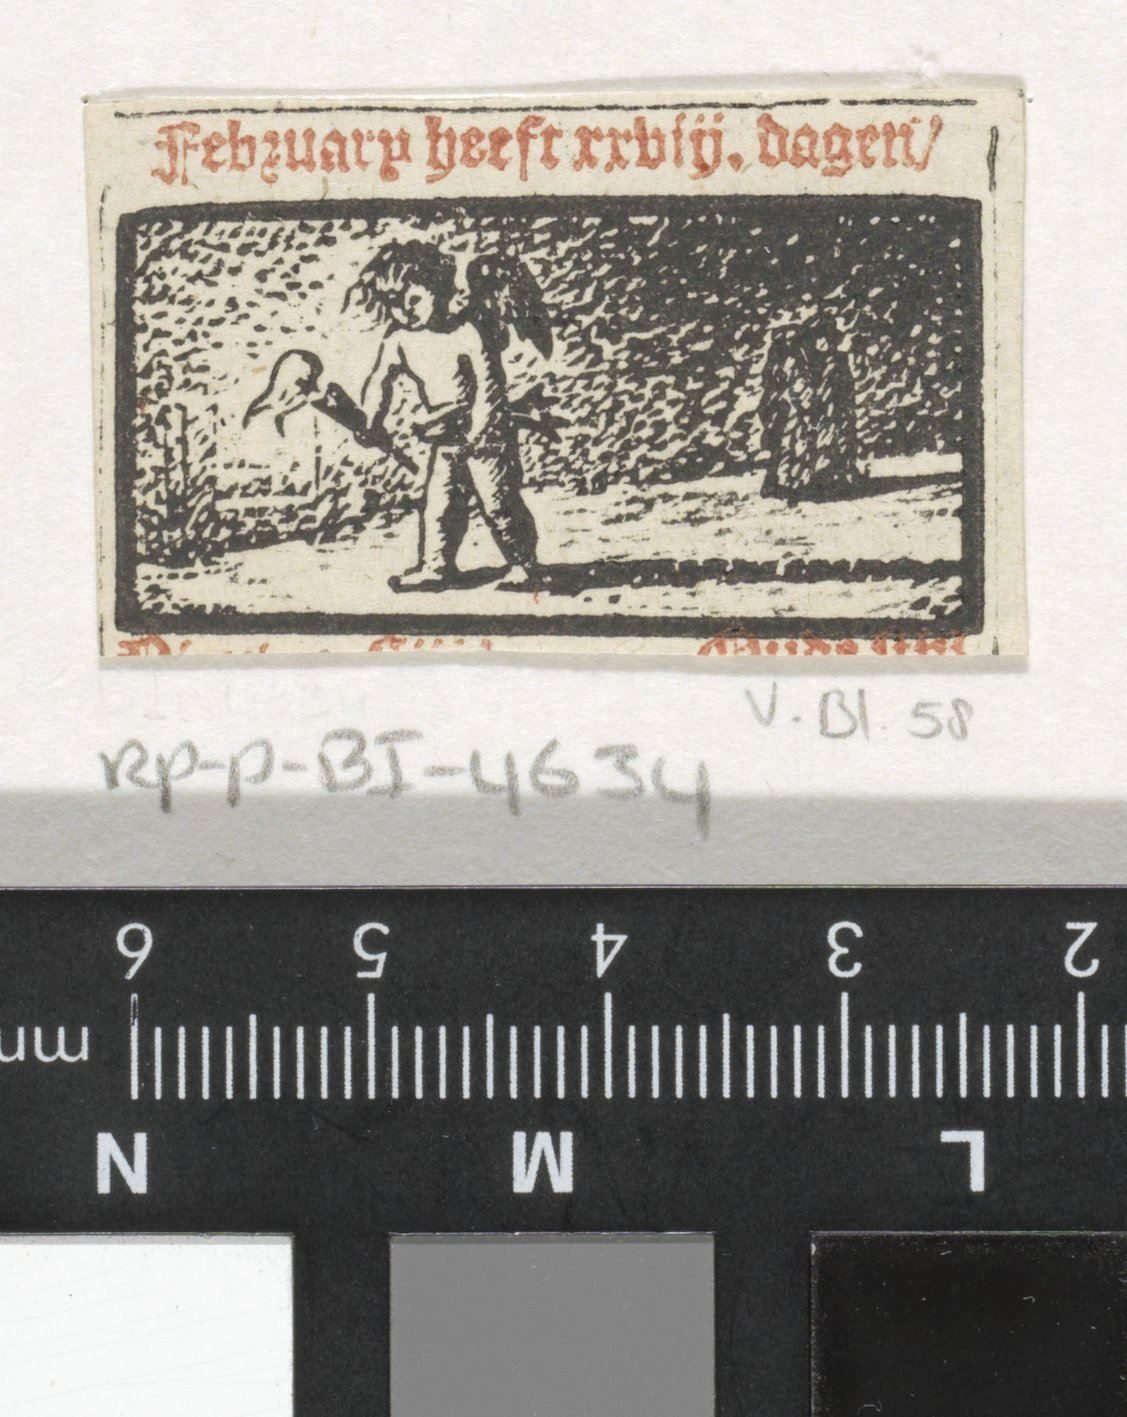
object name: print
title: Februari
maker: dirck de bray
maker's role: draughtsman, painter, print maker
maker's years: 1625-1694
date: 1635-1694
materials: paper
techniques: letterpress printing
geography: netherlands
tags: february and its 'labours' (+ with pisces (february))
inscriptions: collector's mark: Lugt 2228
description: Een putto draagt in zijn linkerhand vissen en in zijn rechterhand een fakkel. In de bovenmarge een regel Nederlandse tekst.